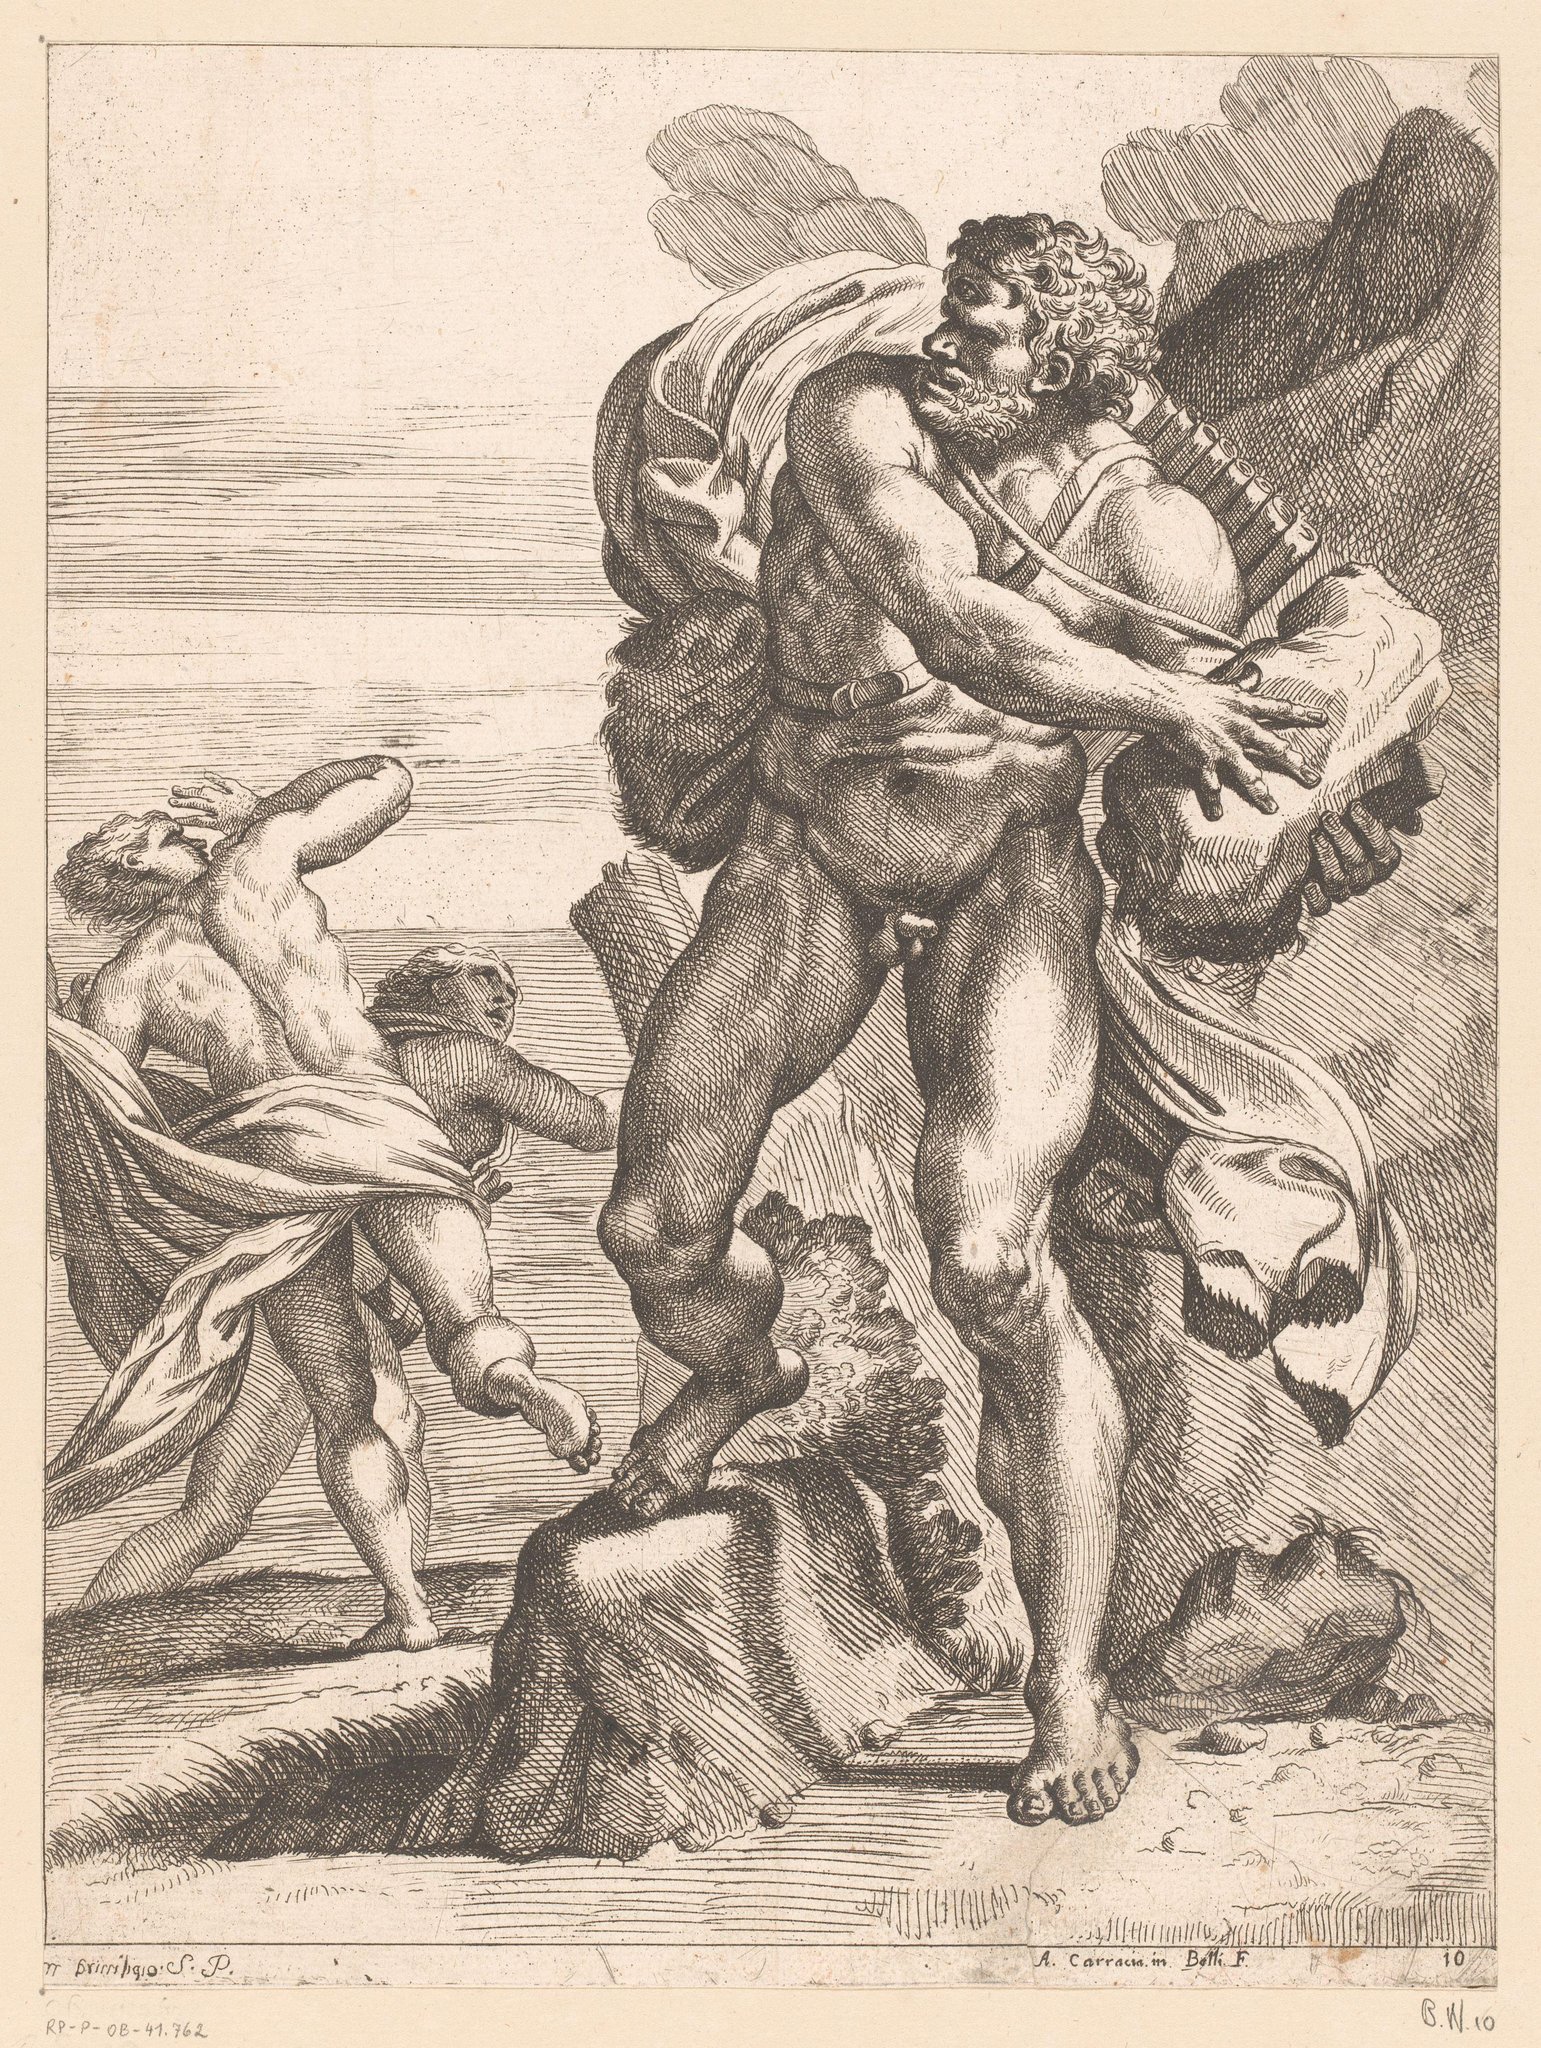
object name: print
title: Polyphemus gooit een steen naar de vluchtende Acis en Galathea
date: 1641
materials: paper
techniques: etching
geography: france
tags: acis and galatea flee from polyphemus, who seizes a rock to crush acis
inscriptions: collector's mark: Lugt 240